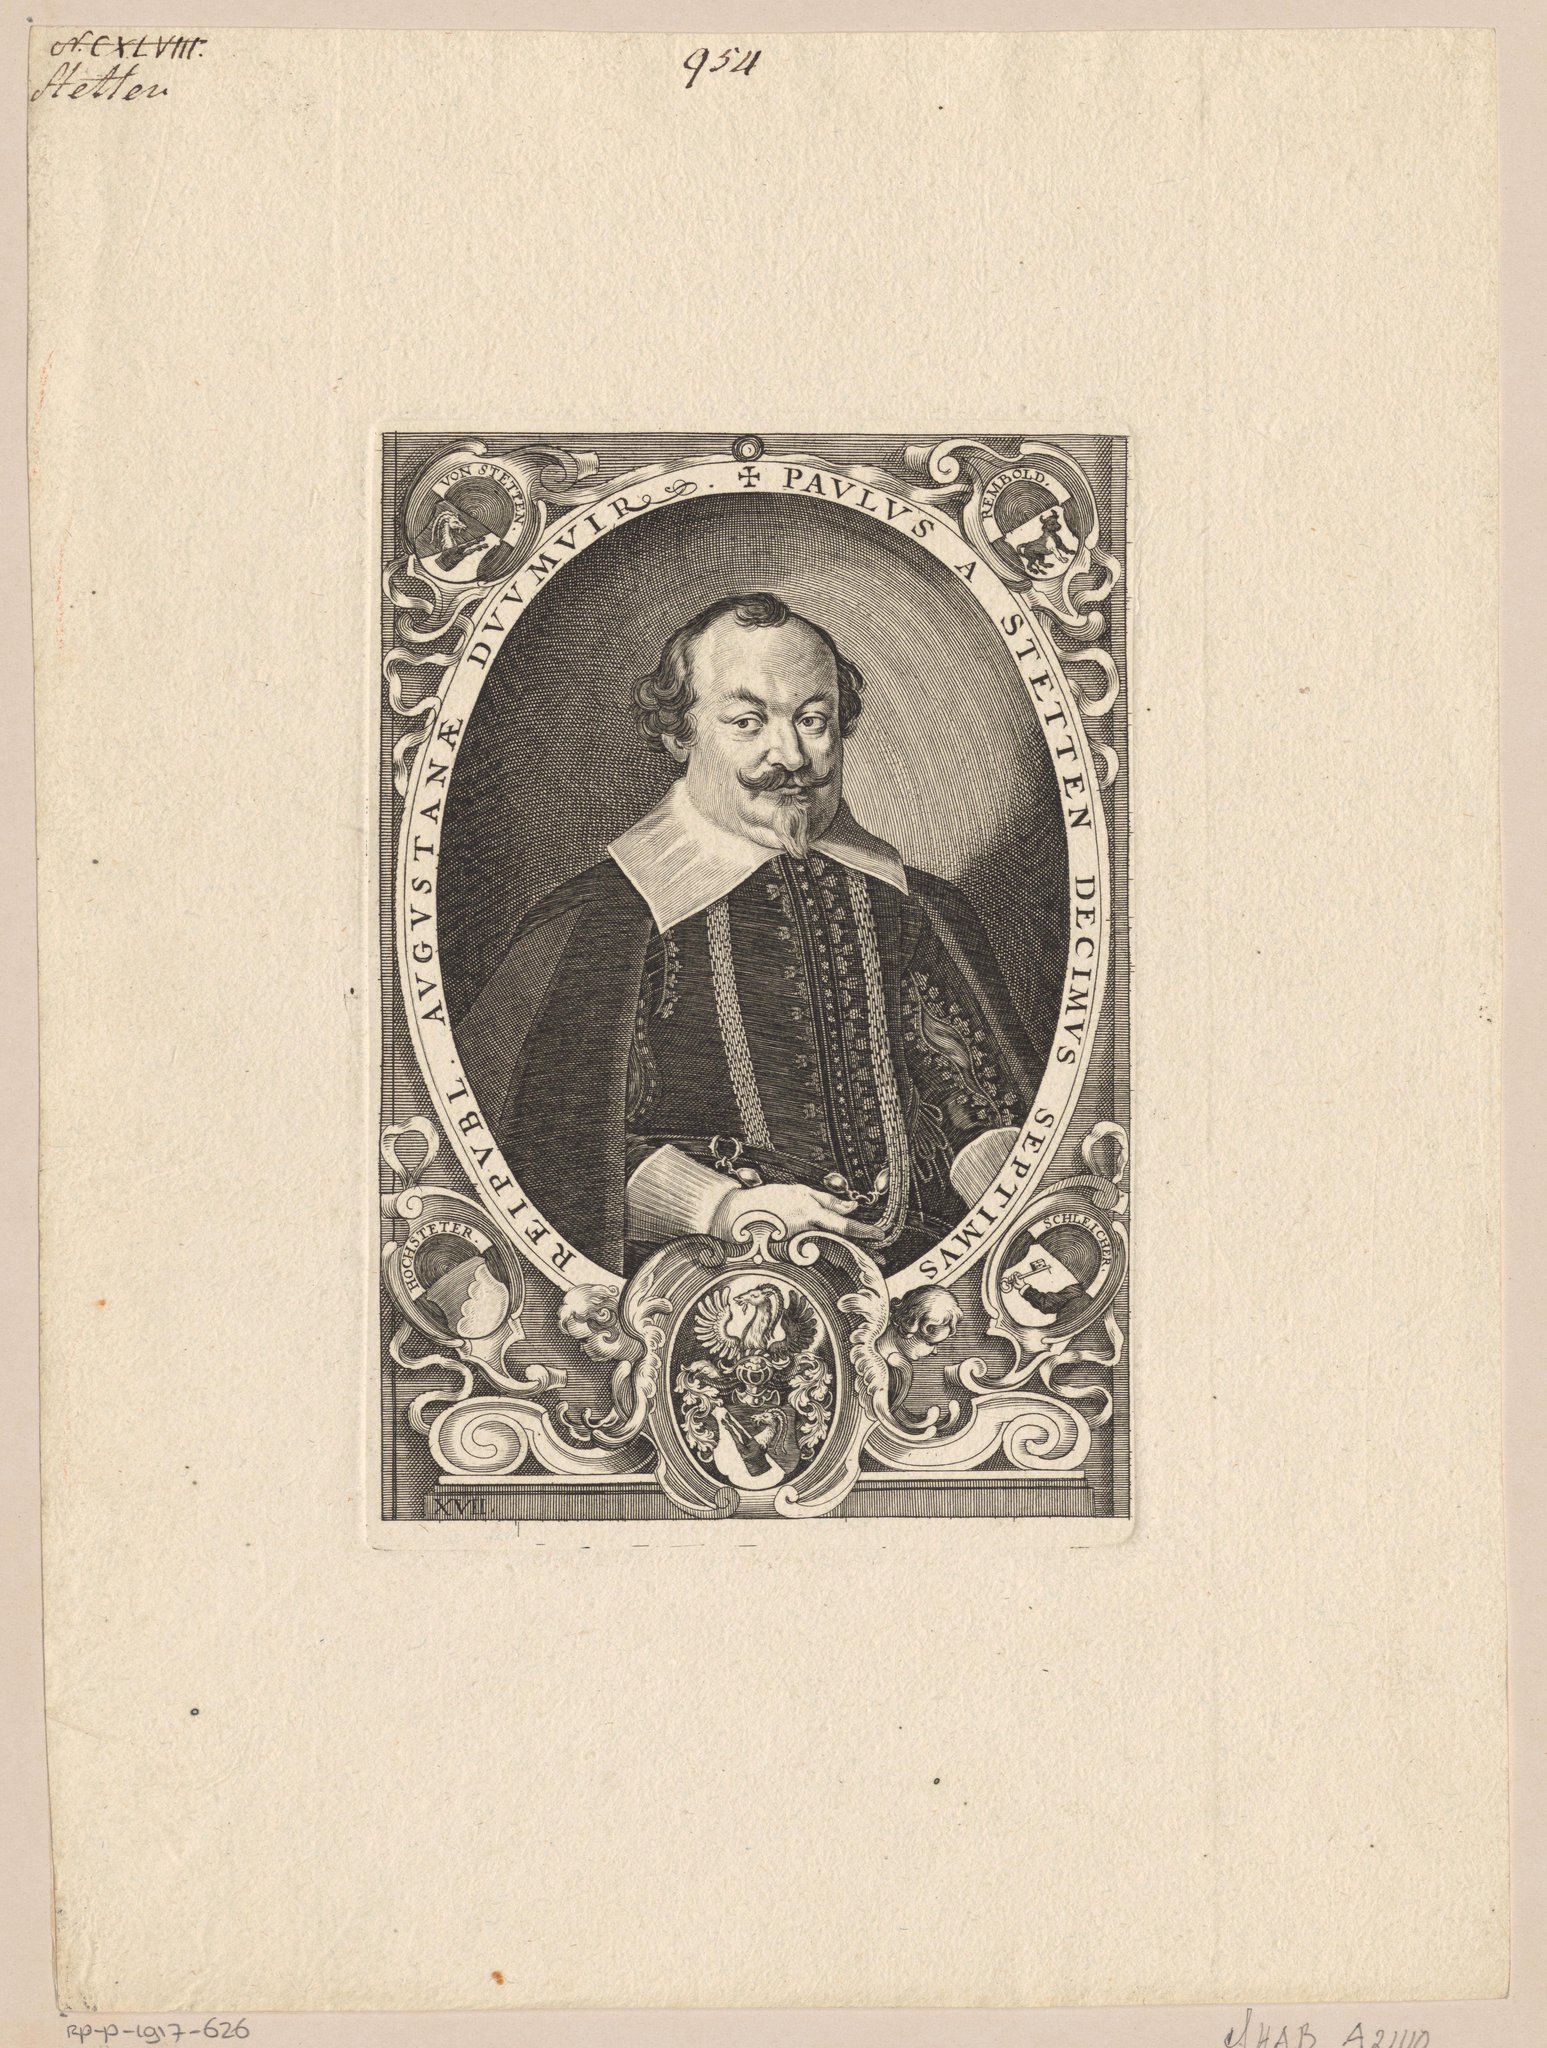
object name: print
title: Portret van Paul von Stetten I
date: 1589-1637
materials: paper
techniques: engraving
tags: mayor, mayor, burgomaster, historical persons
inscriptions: inscription: ‘N. CXLVIII. / 954 / Stetten’, collector's mark: Lugt 2228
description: Prent mogelijk uit: Cunterfait des H. Röm. Reichs Statt Augspurg seith Anno 1542 gewesten Haüpter oder Pflegern. Augsburg: s.n., 1657.